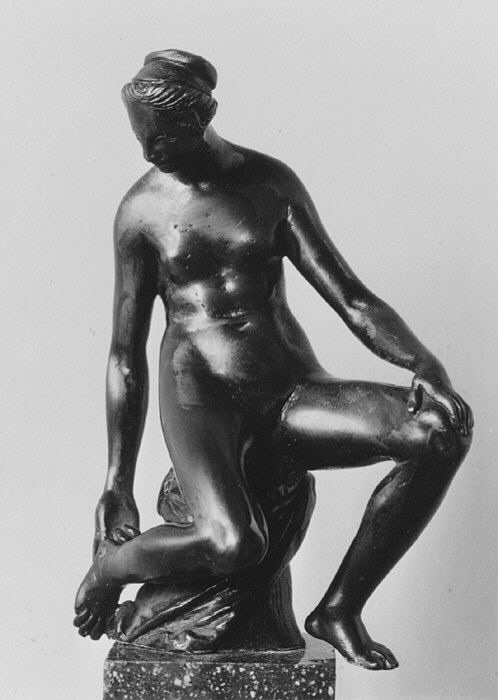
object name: statuette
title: Seated Nude Woman Touching her Foot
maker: barthélemy prieur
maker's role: artist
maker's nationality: french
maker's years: 1536-1611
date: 1601-1633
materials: bronze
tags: feet,female nudes